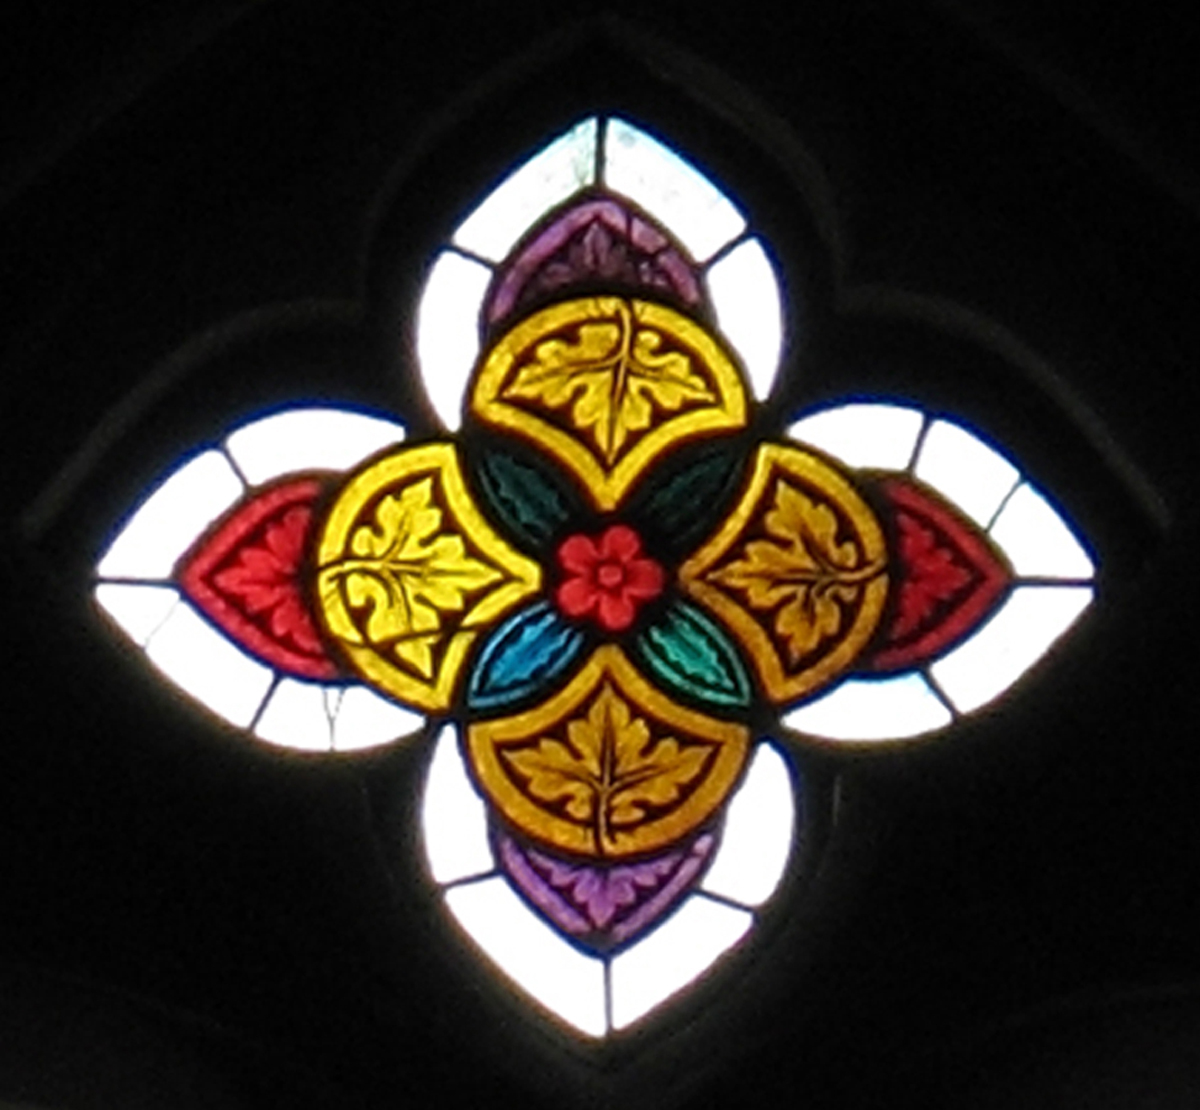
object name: panel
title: Quatrefoil-shaped Tracery Light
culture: austrian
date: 1340-1350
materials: glass, metal, paint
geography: austria